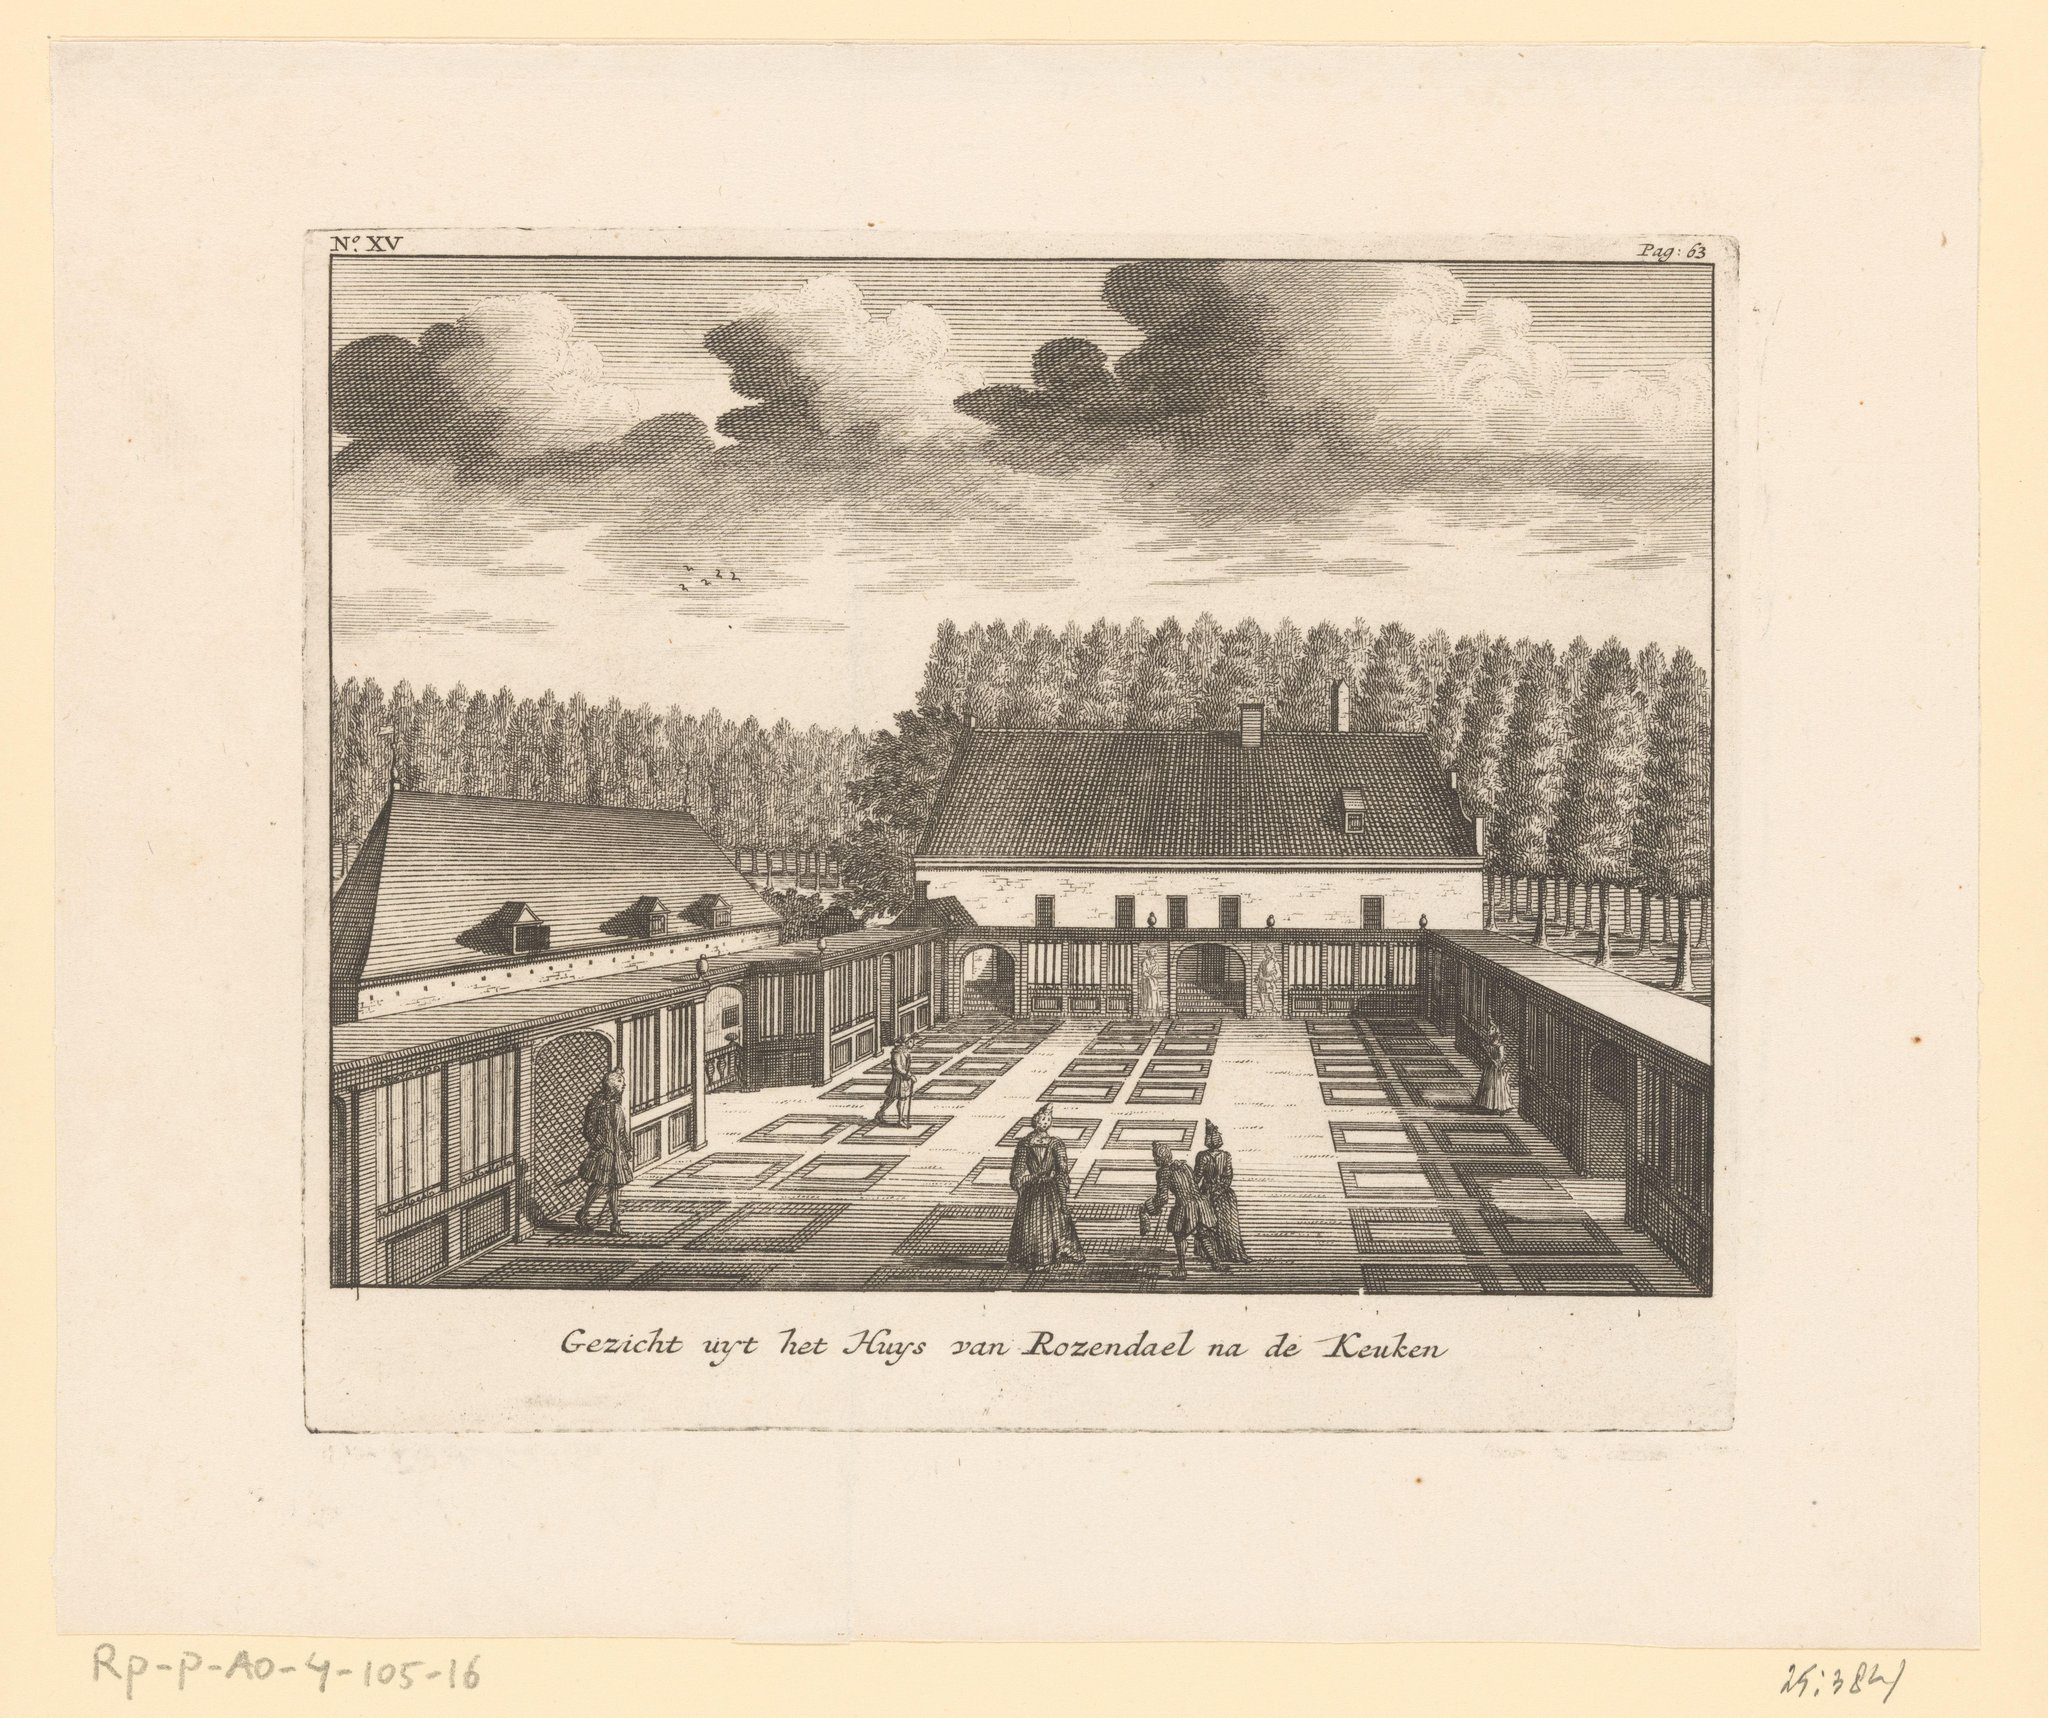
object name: book illustration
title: Gezicht uyt het Huys van Rozendael na de keuken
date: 1718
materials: paper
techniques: engraving, etching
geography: amsterdam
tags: castle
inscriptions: collector's mark: Lugt 195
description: Prent ook gebruikt in: Outrein, Johannes d’. Wegwyser door de heerlykheid Roosendaal ofte, de Roosendaalsche vermakelykheden. 3e druk. Amsterdam: Gerard van Keulen, 1718.